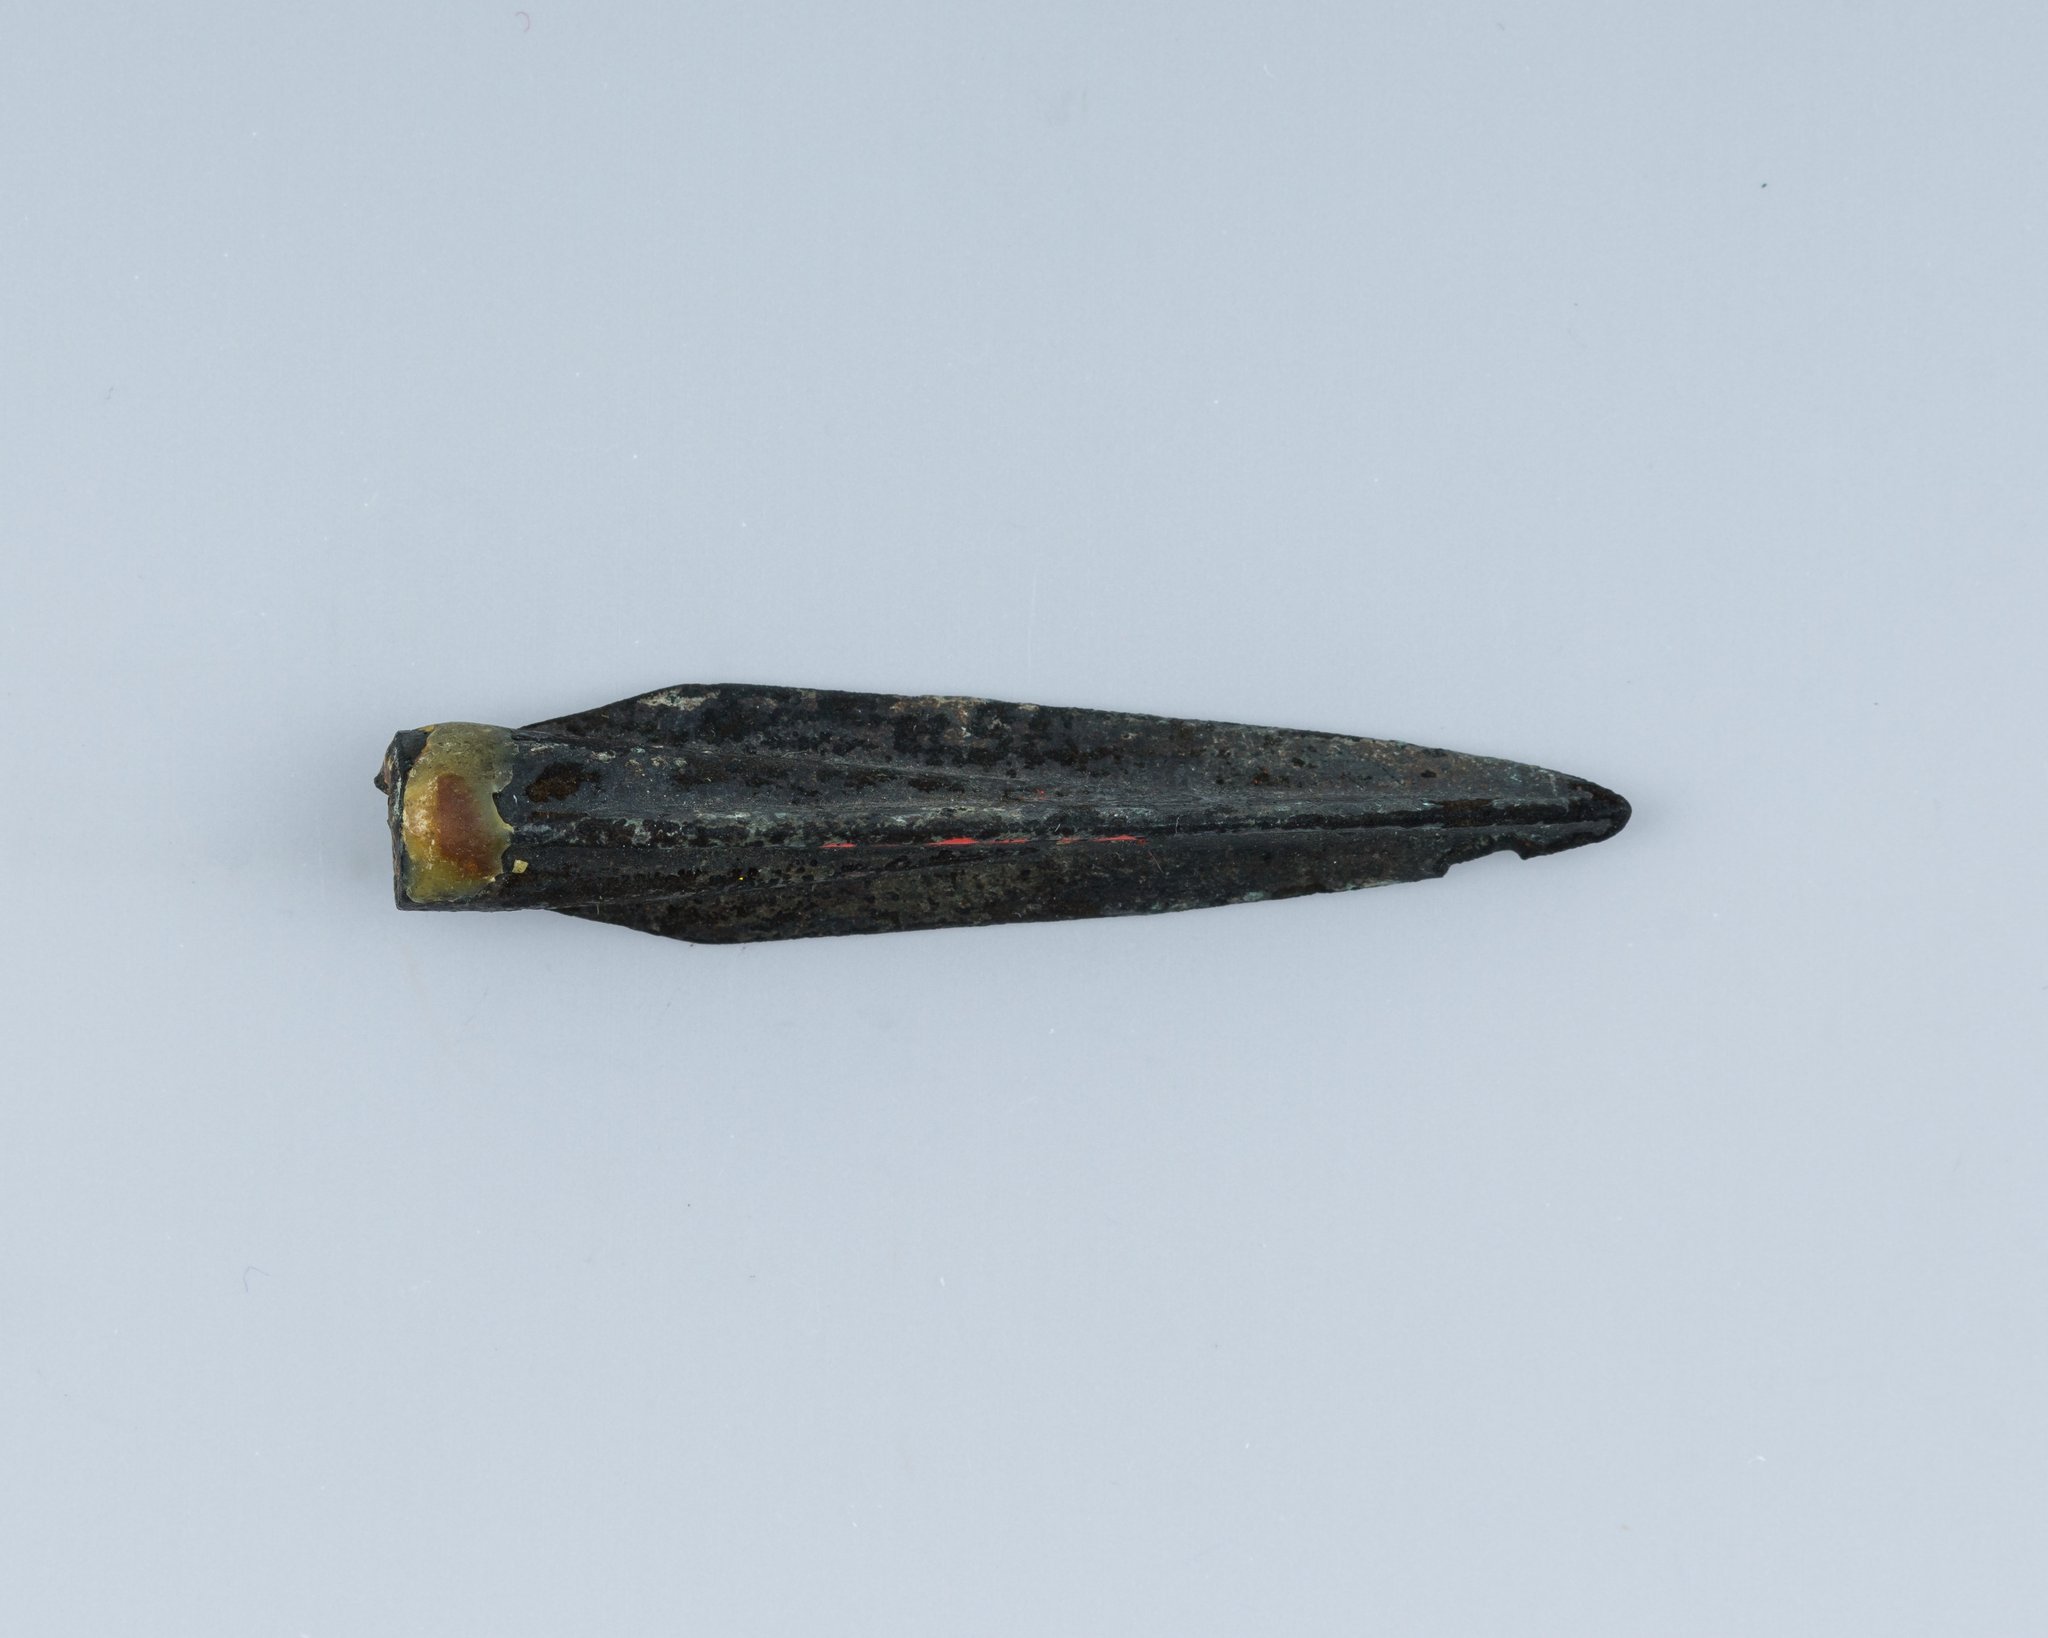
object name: three arrowhead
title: Three Arrowheads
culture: greco-egyptian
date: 332-330 BCE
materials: bronze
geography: egypt